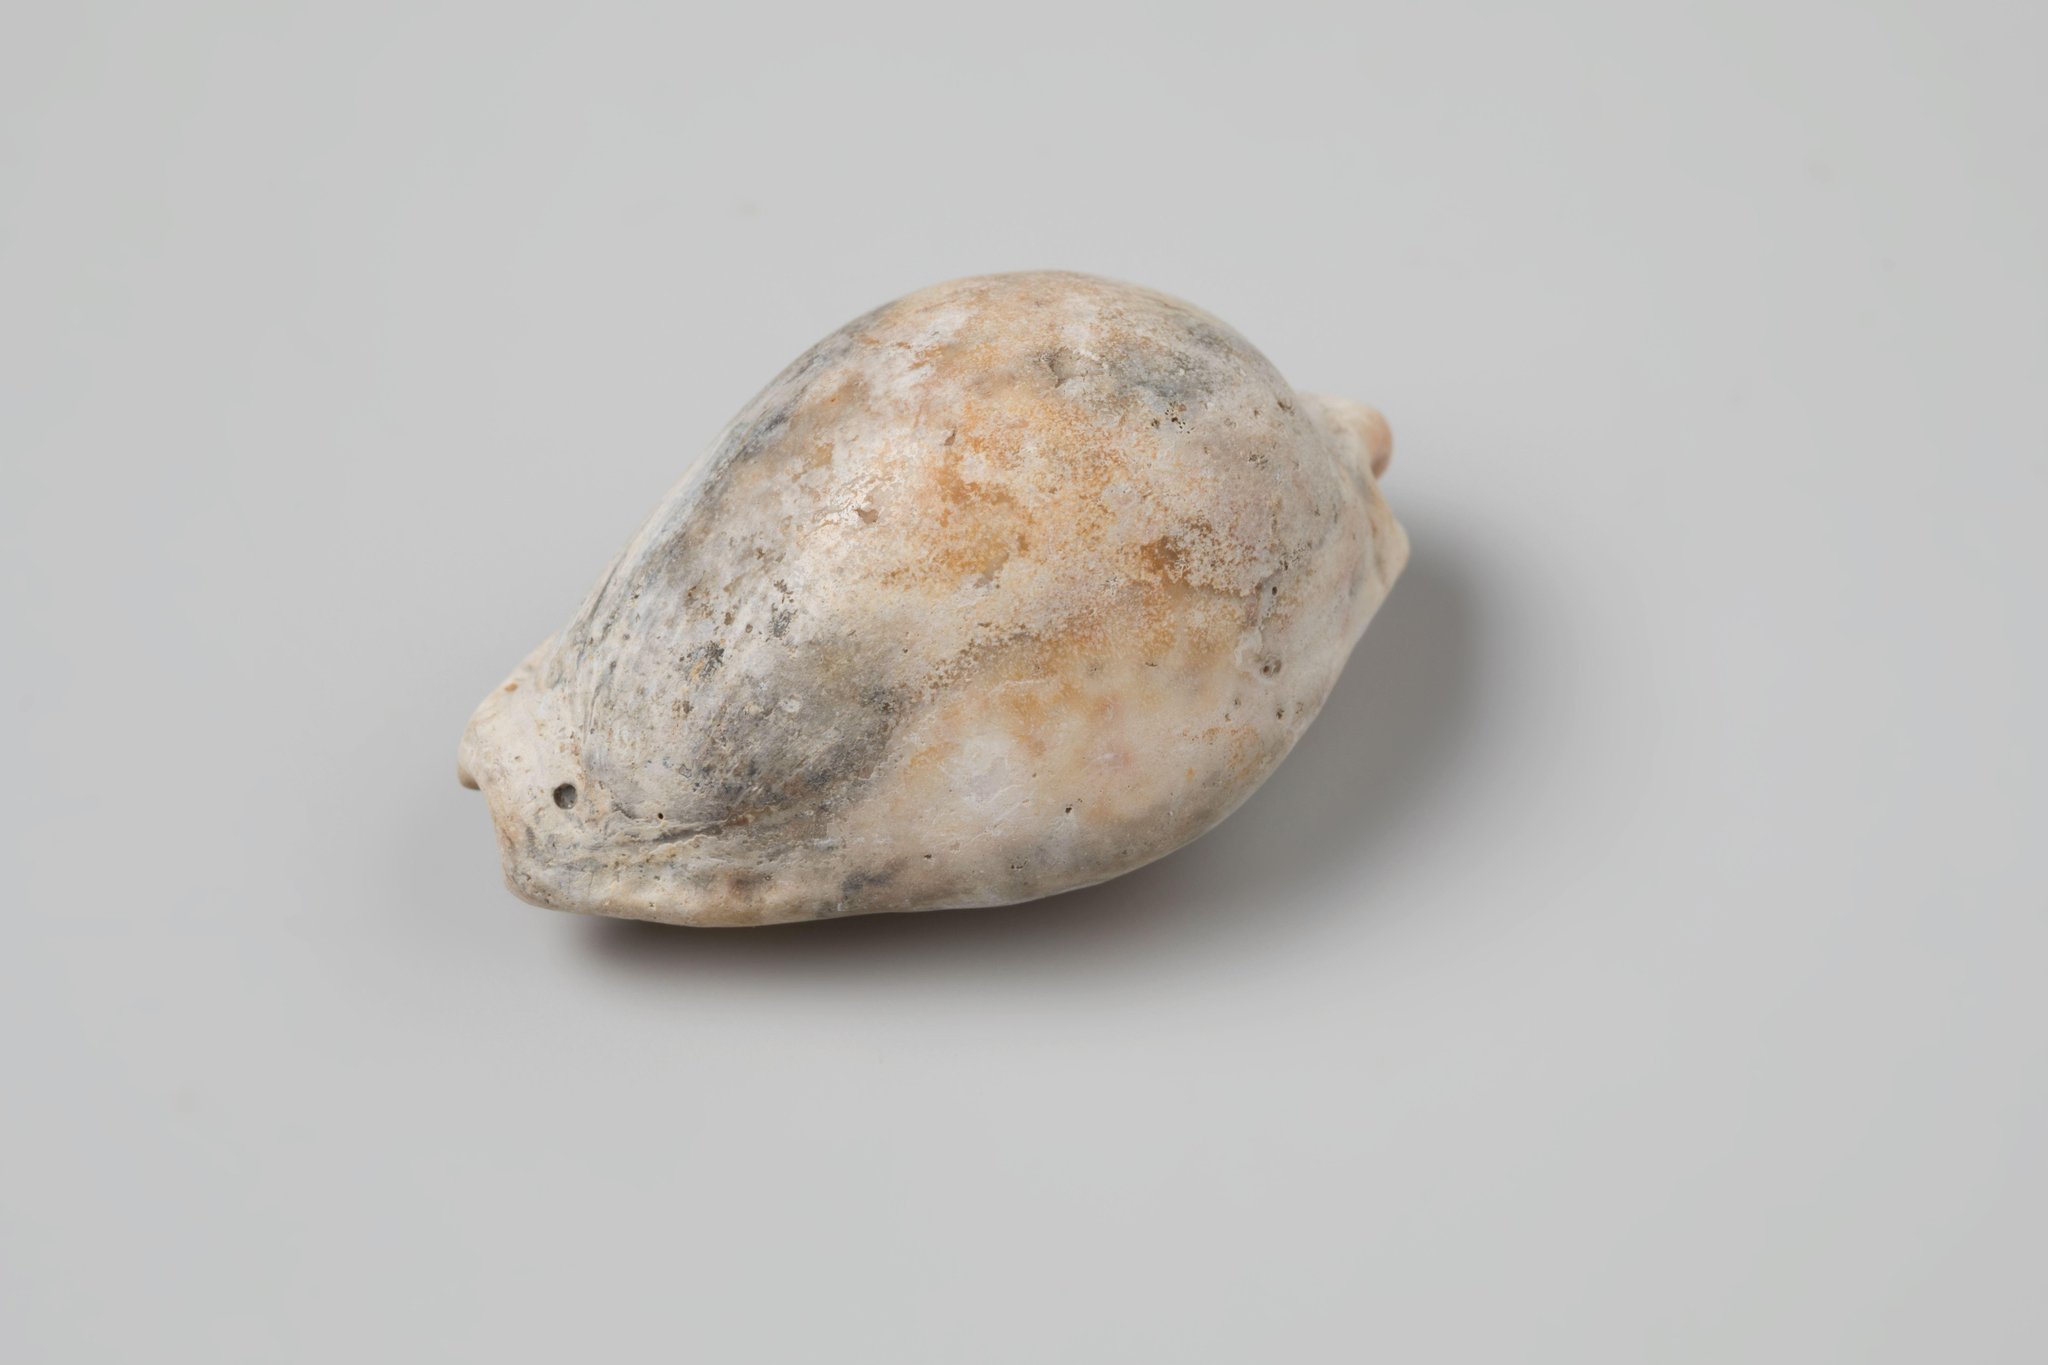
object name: shell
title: Kauri shell from the wreck of the Dutch East India ship Witte Leeuw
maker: niet van toepassing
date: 1613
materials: shell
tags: verenigde oostindische compagnie, sint-helena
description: Schelp van een slak uit V.O.C.-schip de 'Witte Leeuw'.